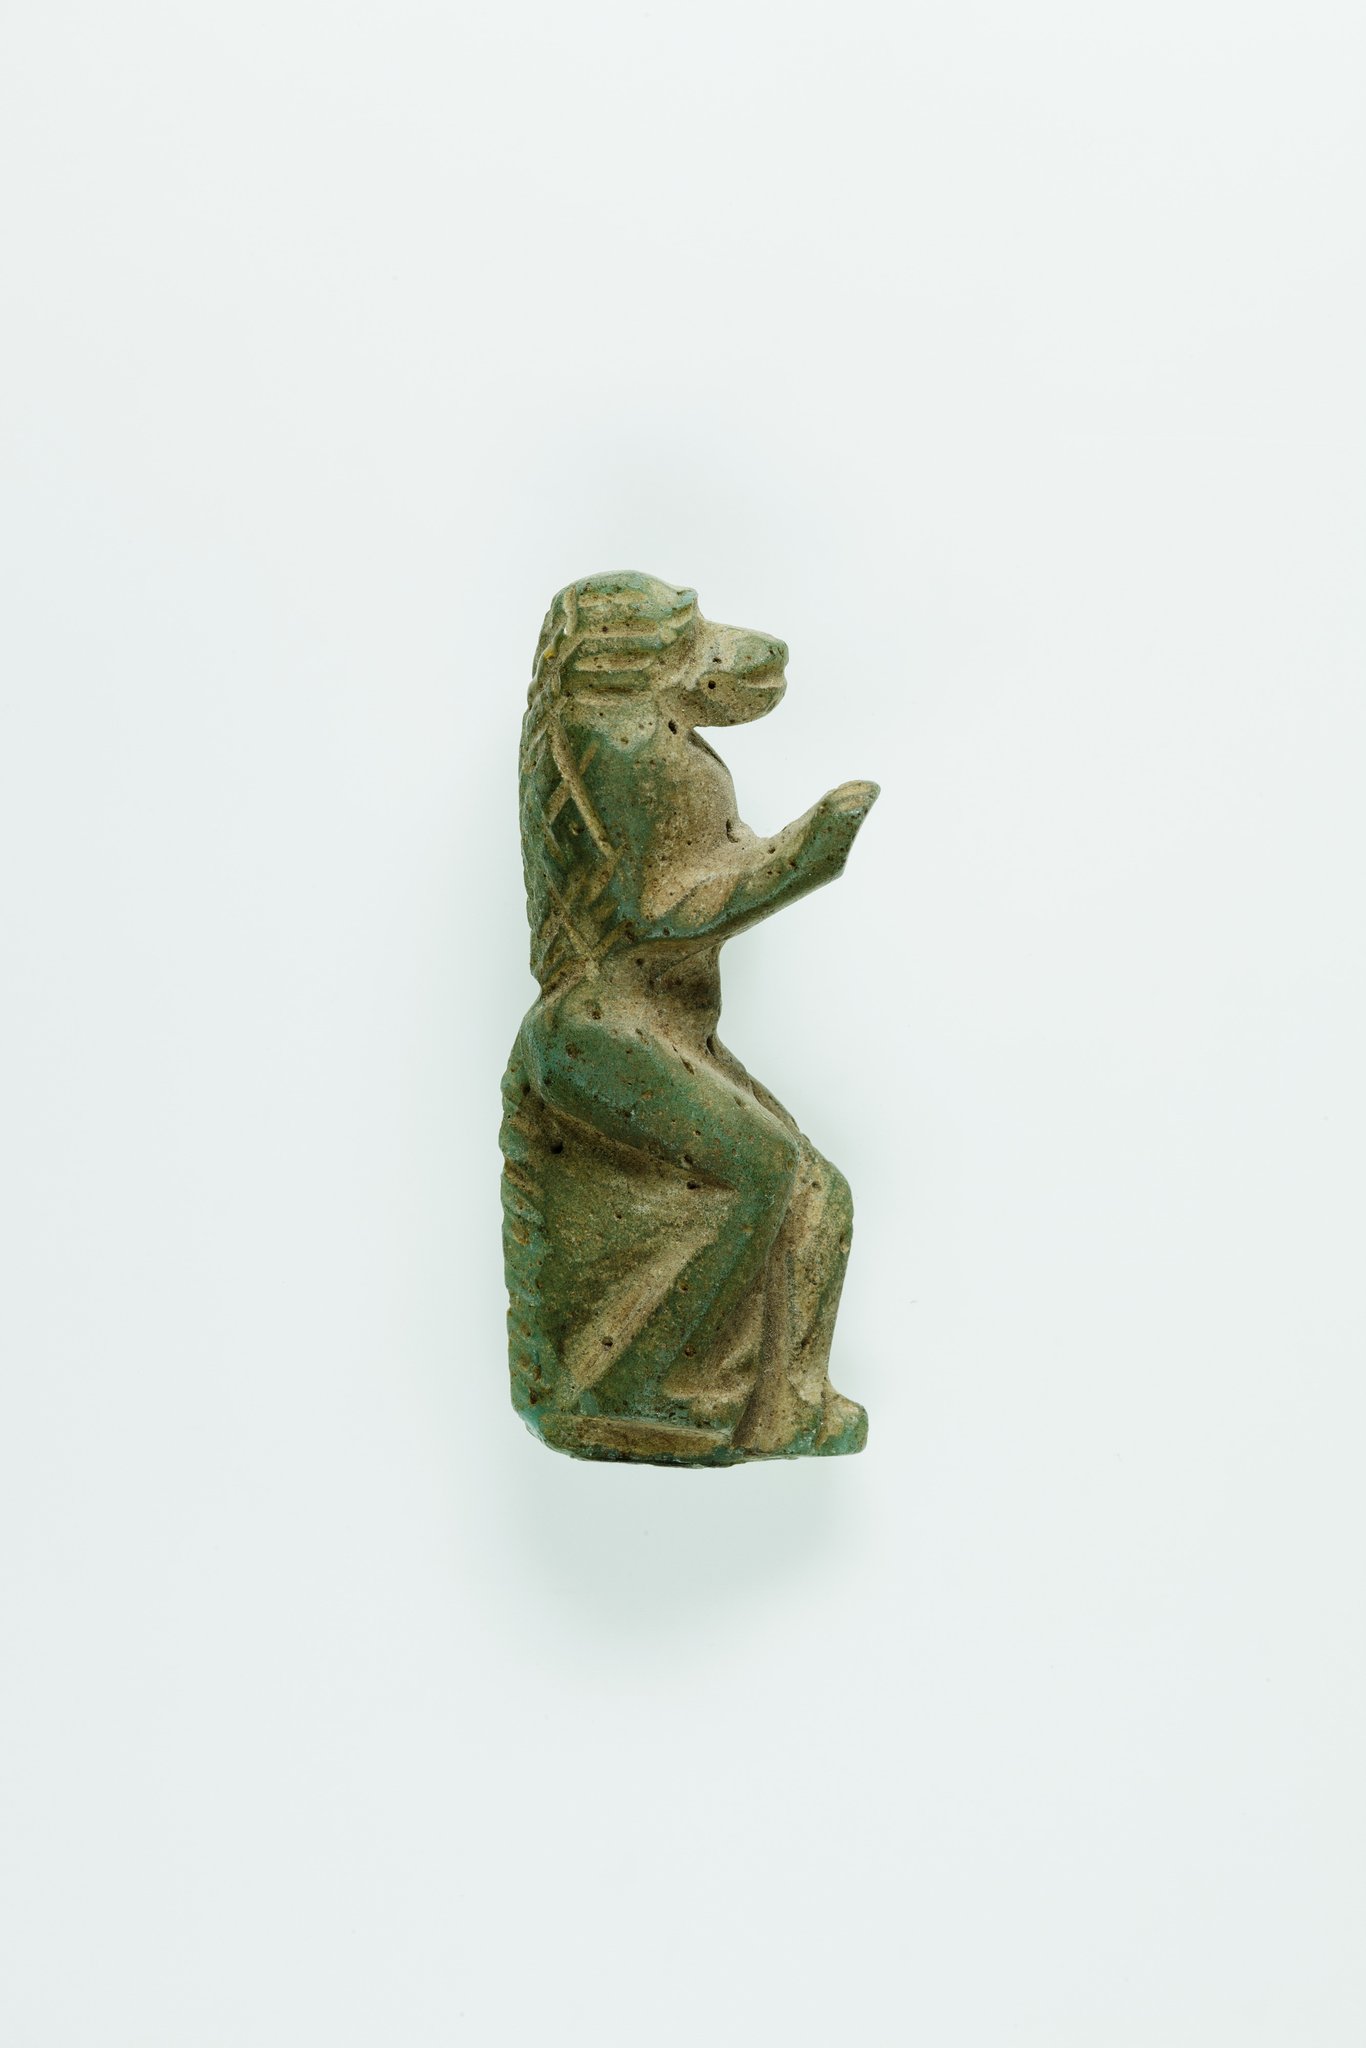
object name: amulet, baboon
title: Baboon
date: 664-630 BCE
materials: glass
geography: egypt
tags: baboons